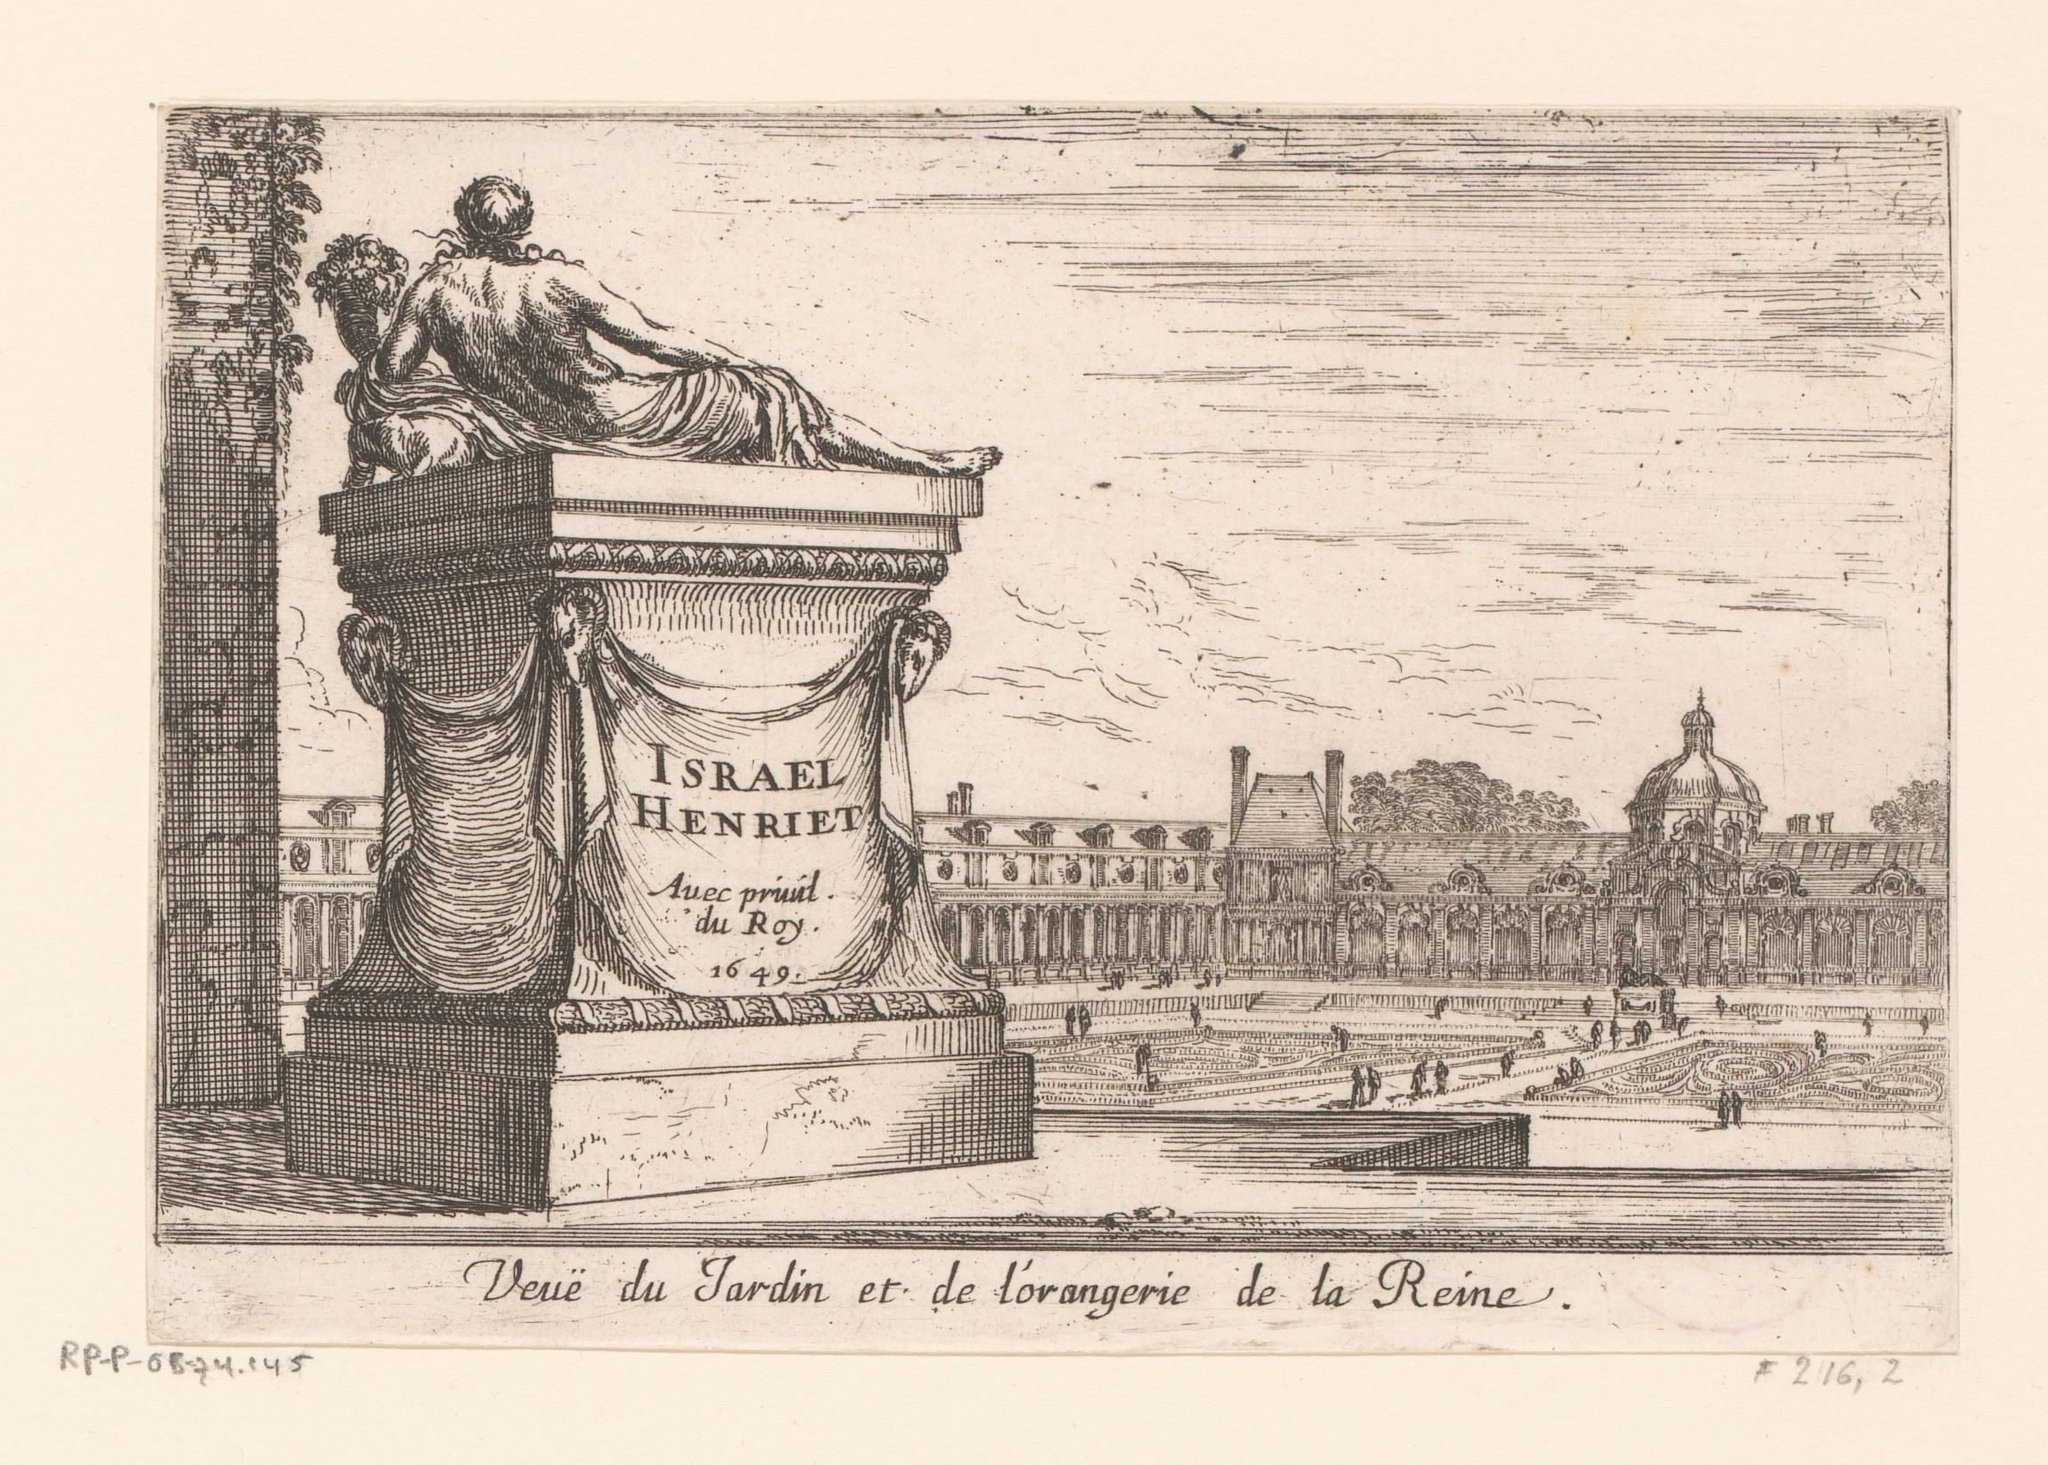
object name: print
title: Diverse vues du Château et des bâtiments de Fontainebleau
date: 1649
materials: paper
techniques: engraving, etching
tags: french or architectonic garden; formal garden, landscape with tower or castle (+ city(-scape) with figures, staffage)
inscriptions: collector's mark: Lugt 240